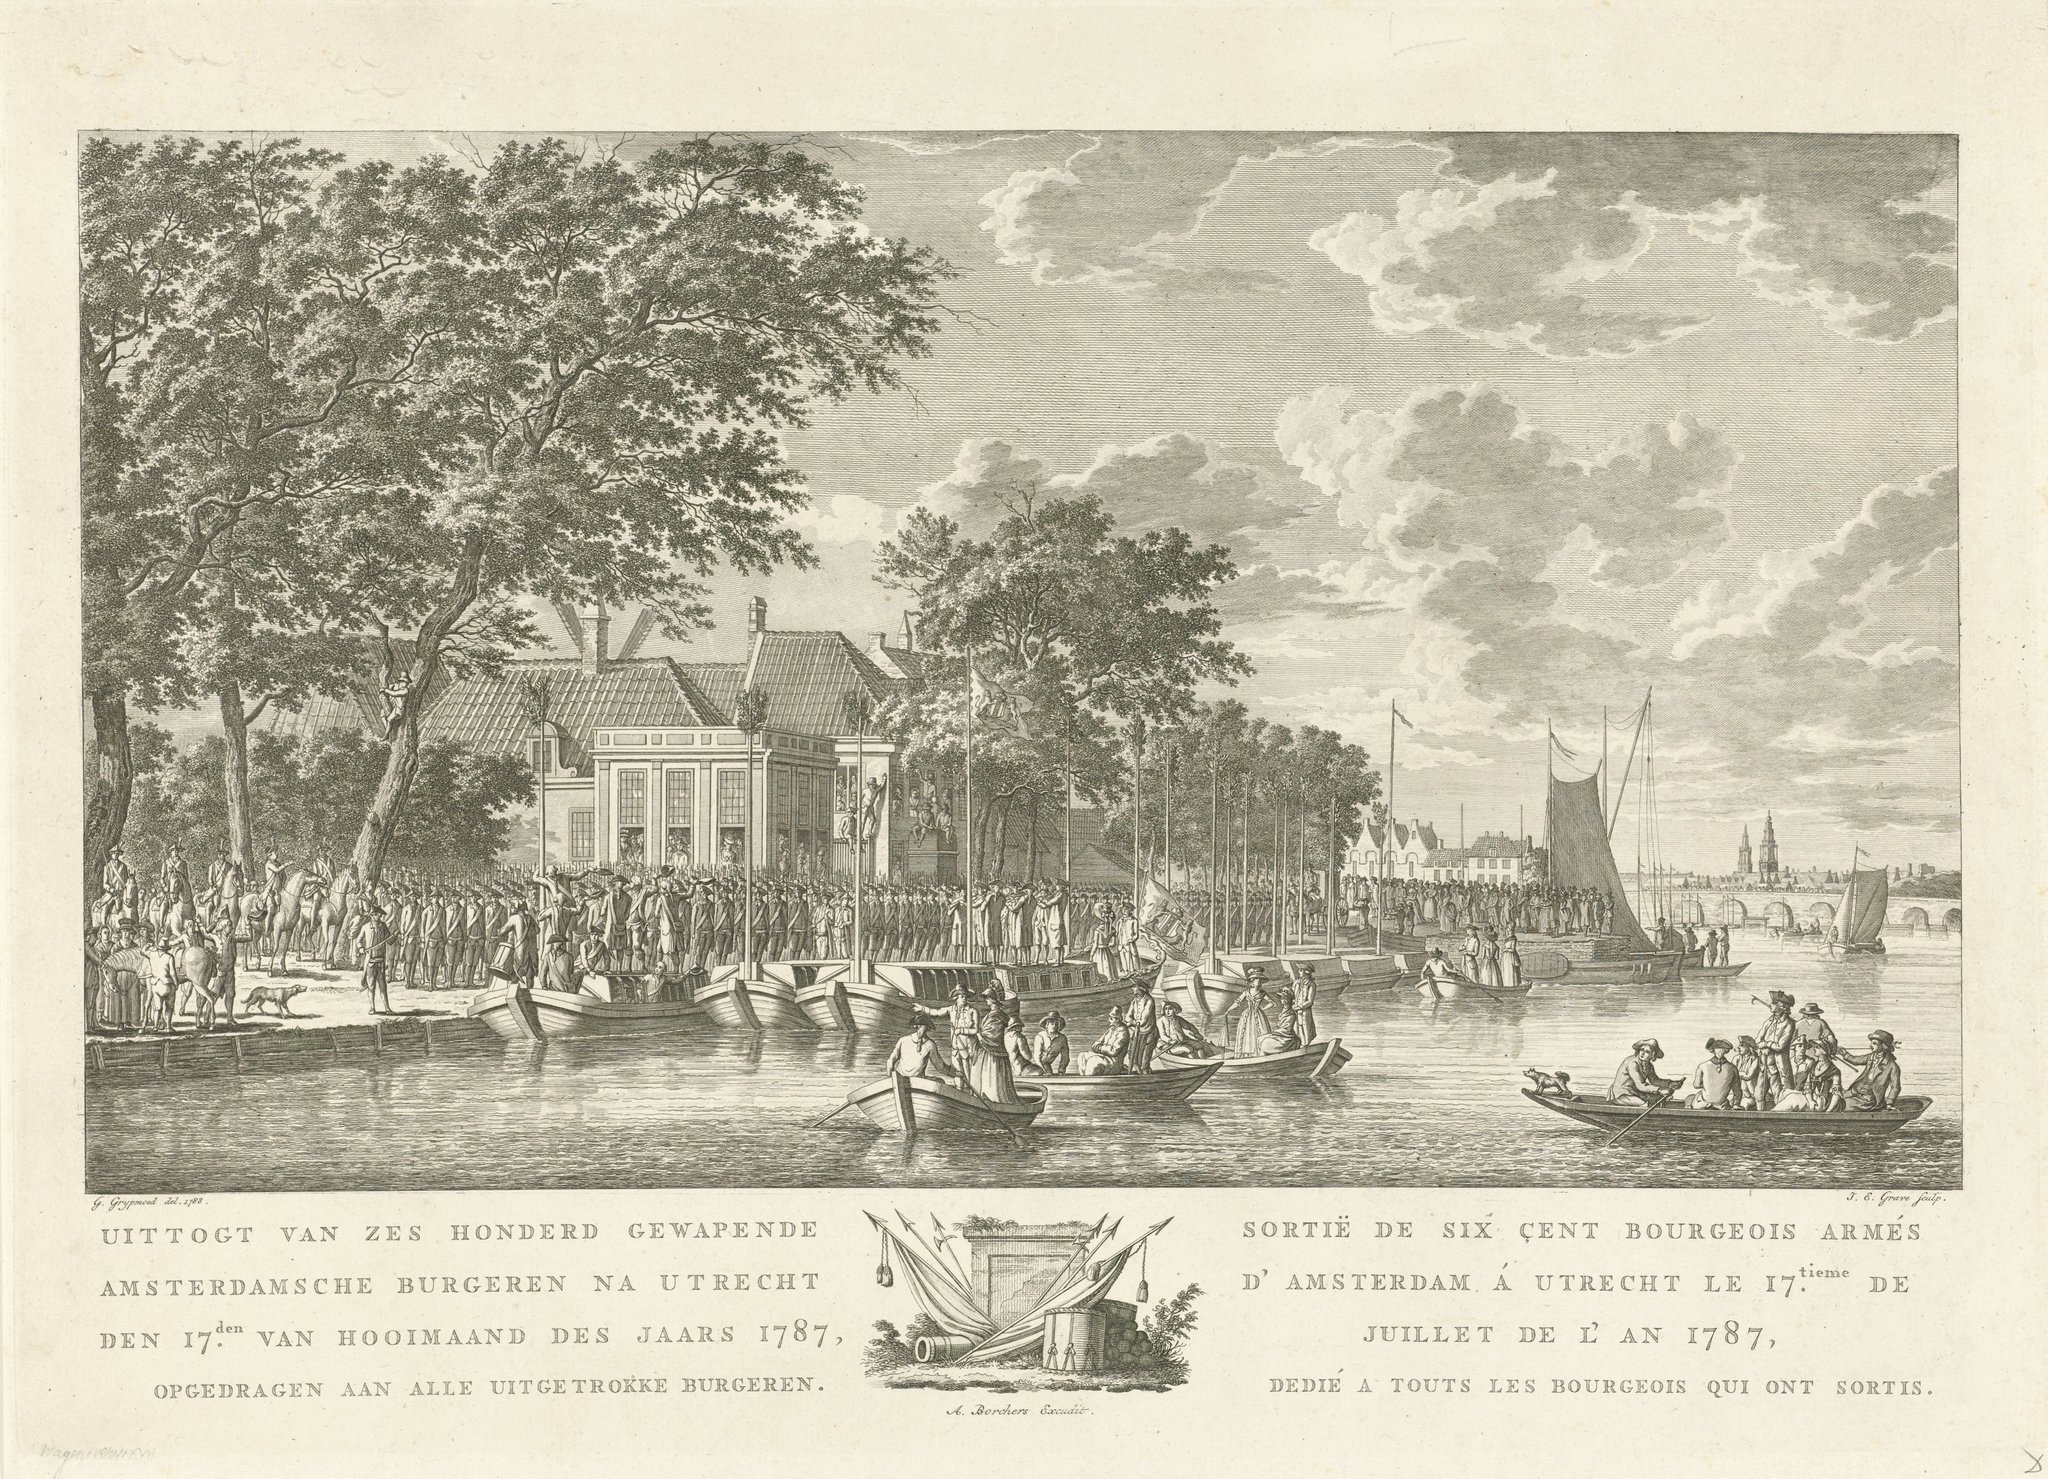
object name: print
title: Uittocht van 600 gewapende Amsterdamse burgers naar Utrecht, 17 juli 1787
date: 1788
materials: paper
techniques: engraving, etching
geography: amsterdam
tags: patriots (1780-1795)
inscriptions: collector's mark: Lugt 2228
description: Onder het toeziend oog van het toegestroomd publiek bij herberg de Berebijt vertrekken zeshonderd Amsterdamse burgers op 17 juli 1787 uit Amsterdam naar Utrecht, om daar het patriottenleger aan te vullen. De prent heeft een Nederlands en Frans onderschrift.